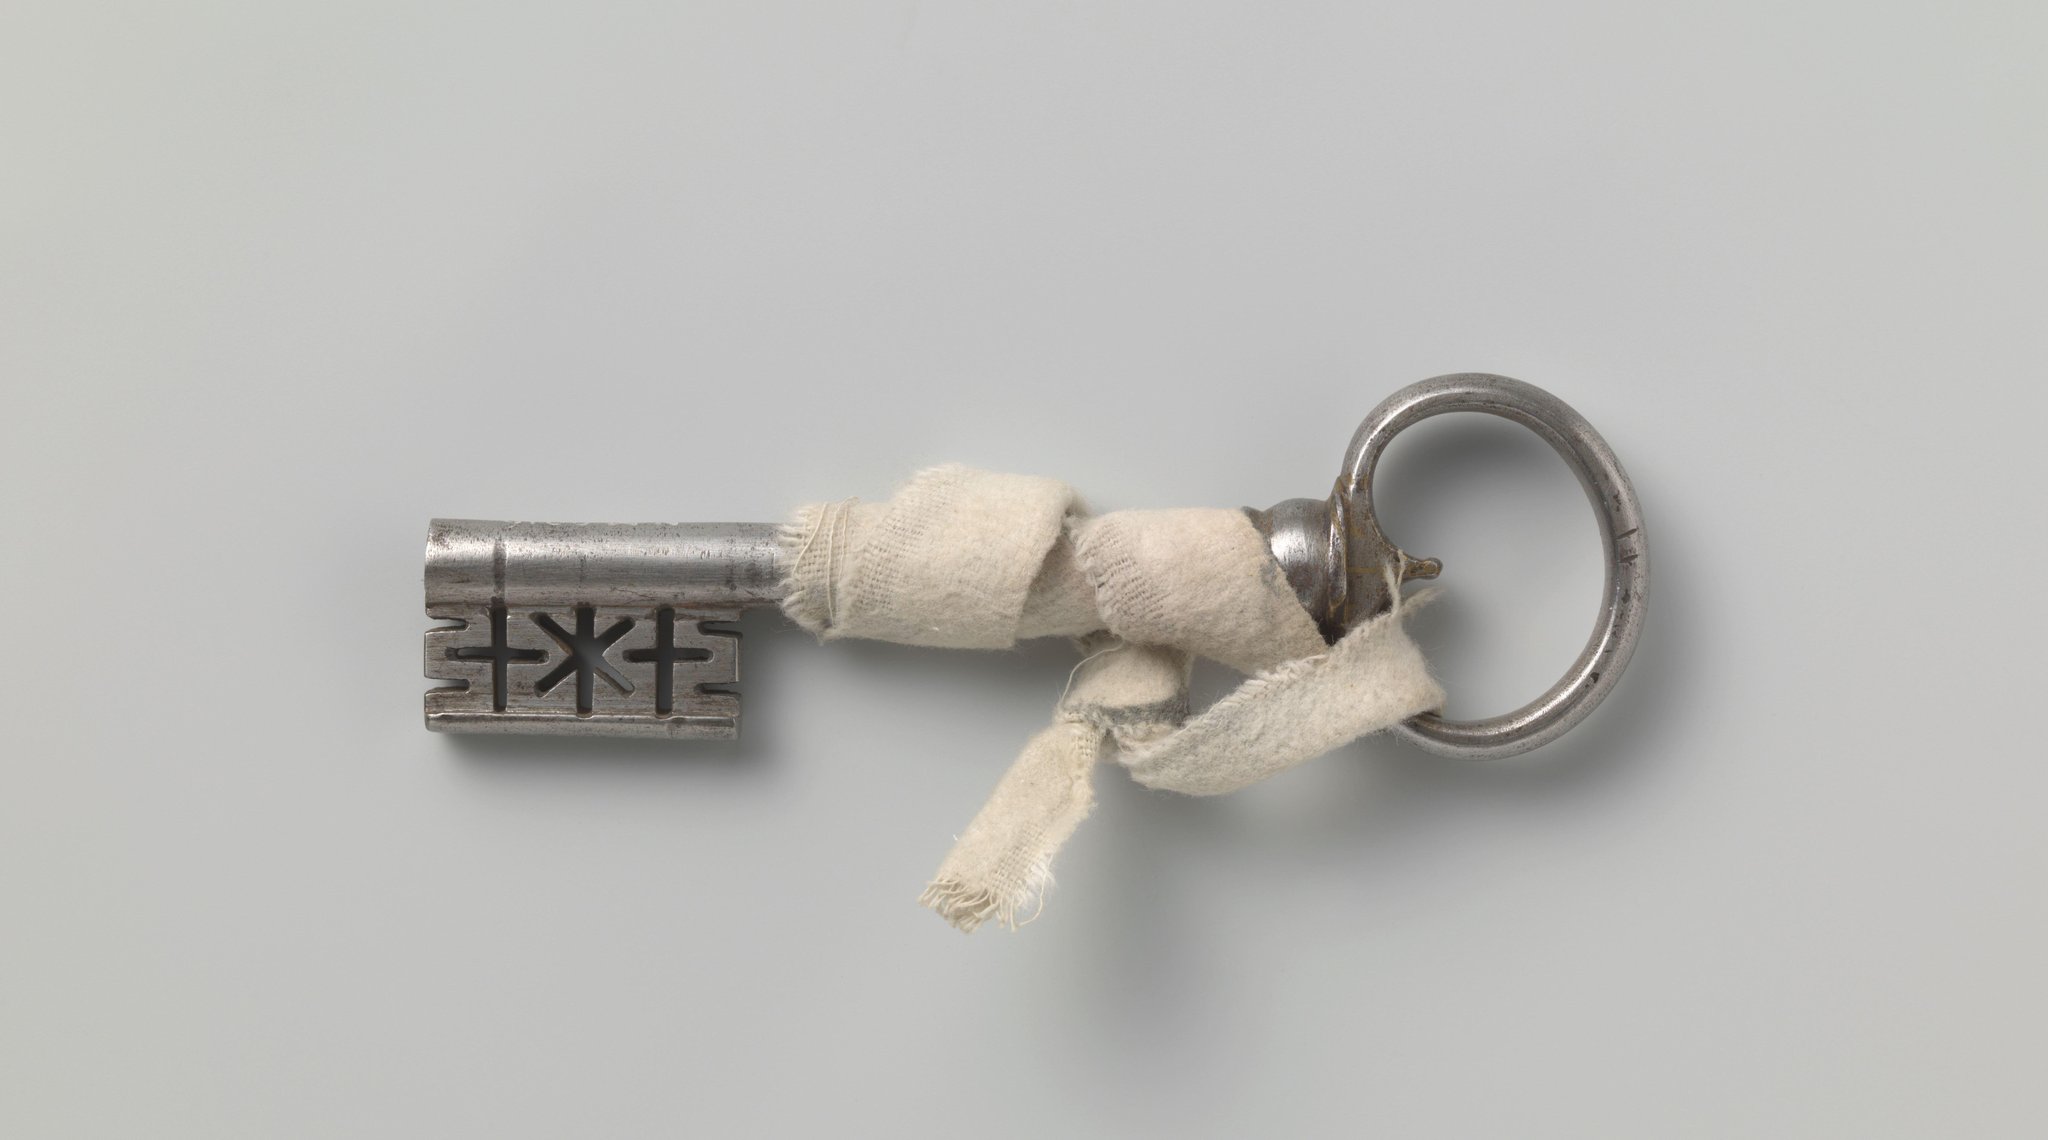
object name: key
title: Sleutel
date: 1400-1950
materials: iron